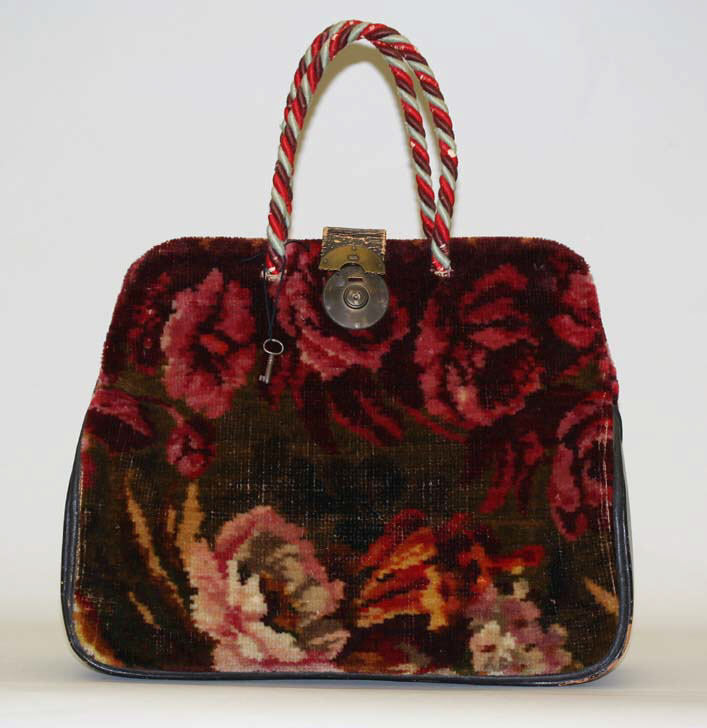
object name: carpetbag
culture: american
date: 1801-1900